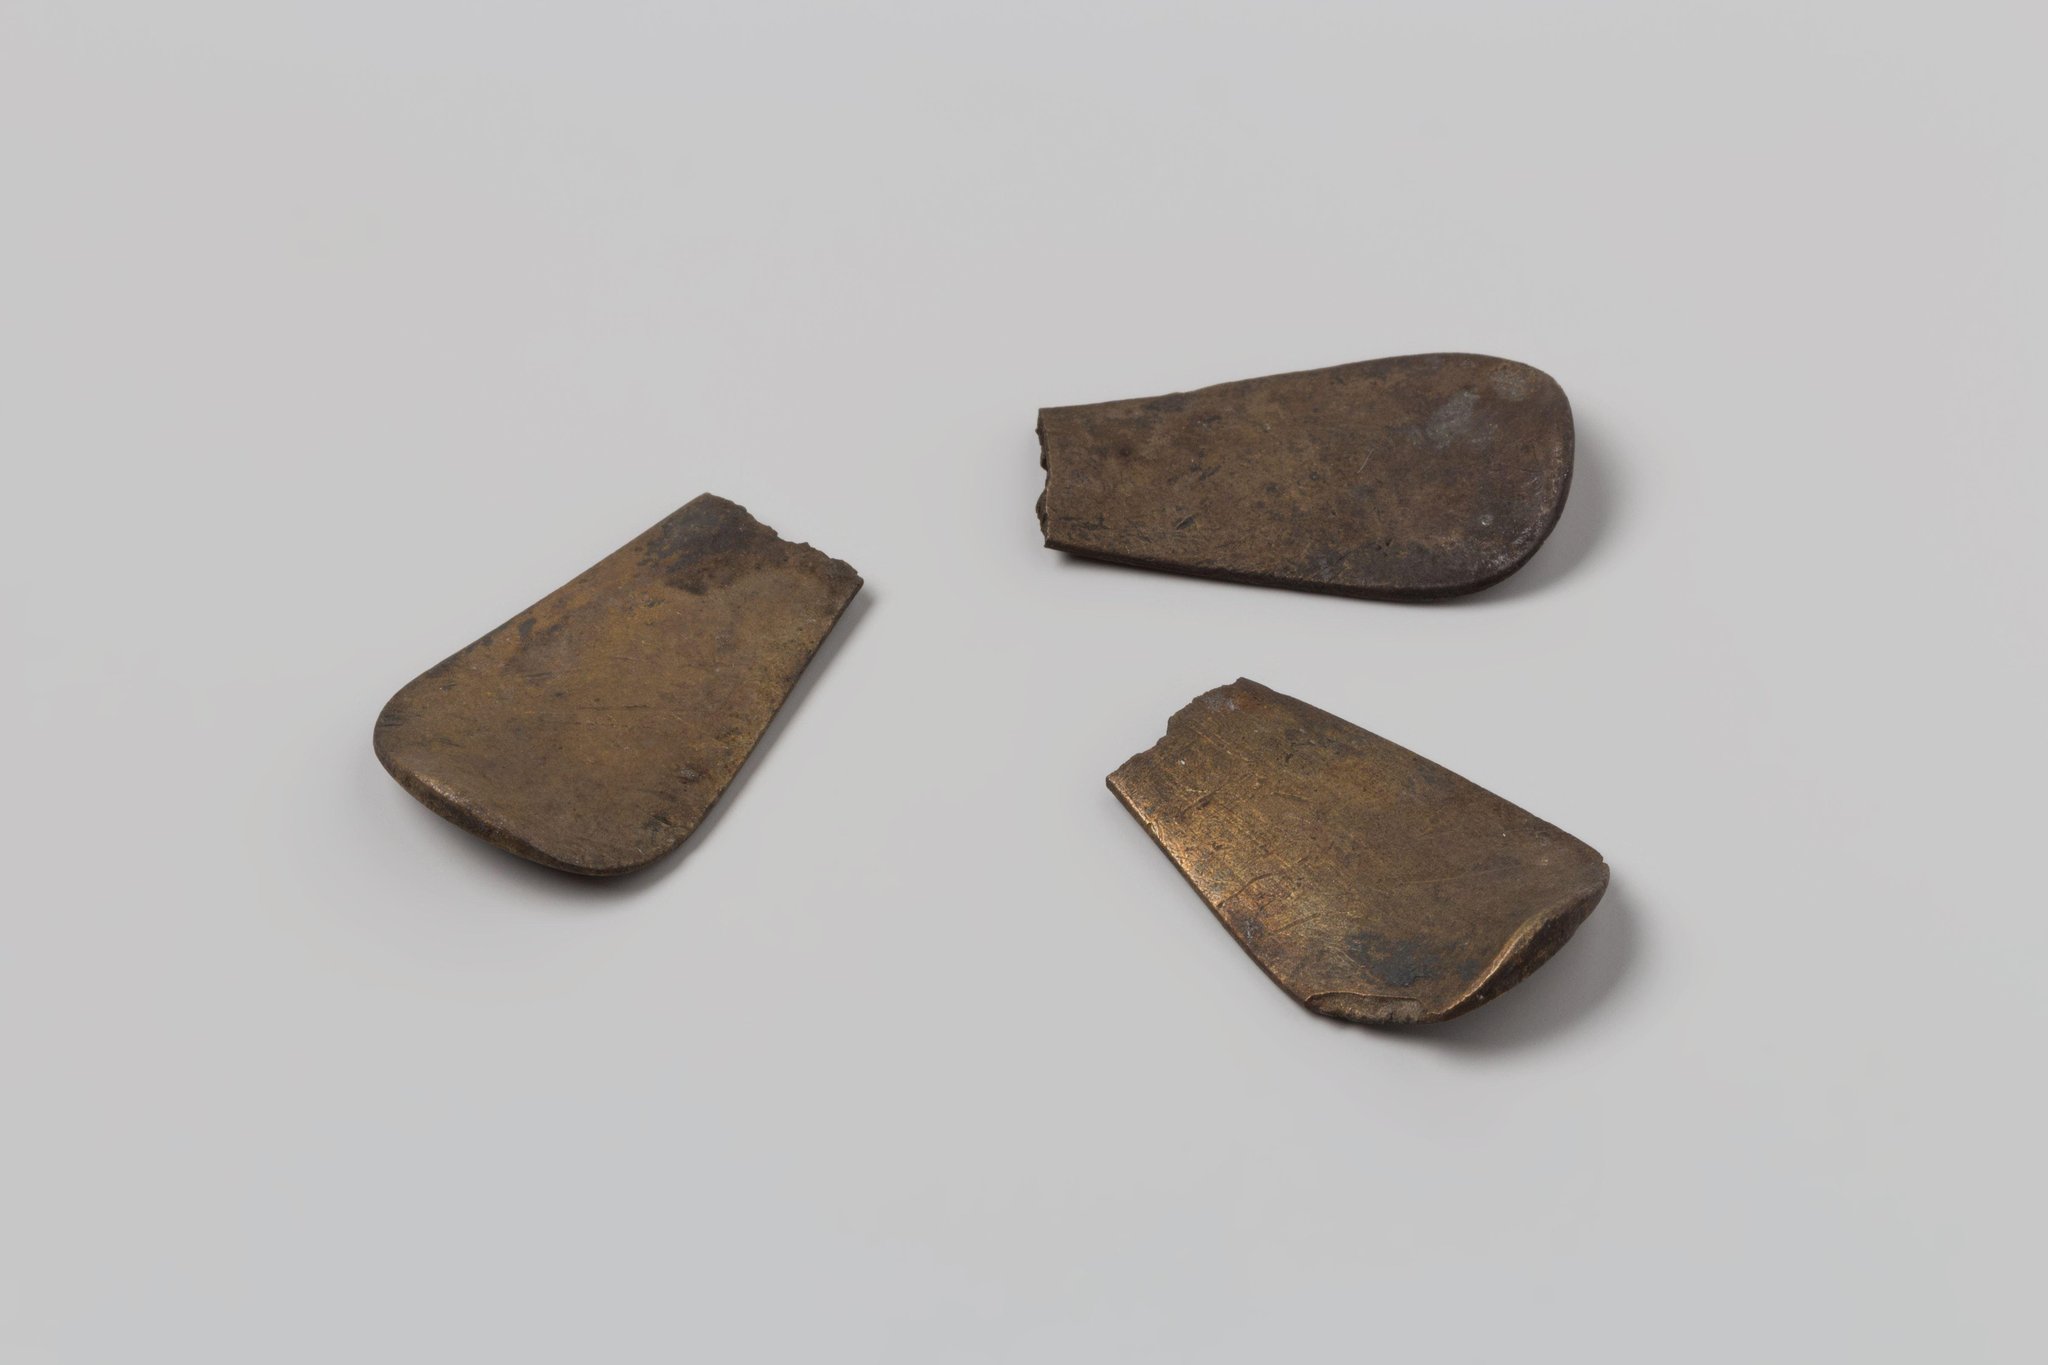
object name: spoon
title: Fragmenten stelen van vork of lepel uit het wrak van de Oost-Indiëvaarder Hollandia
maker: Anonymous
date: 1700-1743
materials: copper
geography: netherlands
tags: verenigde oostindische compagnie, hollandia (schip), annet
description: Cutlery, fragment: stem of fork or spoon; fragm ends, flat, curved, sim. NG 1980-27H3366.